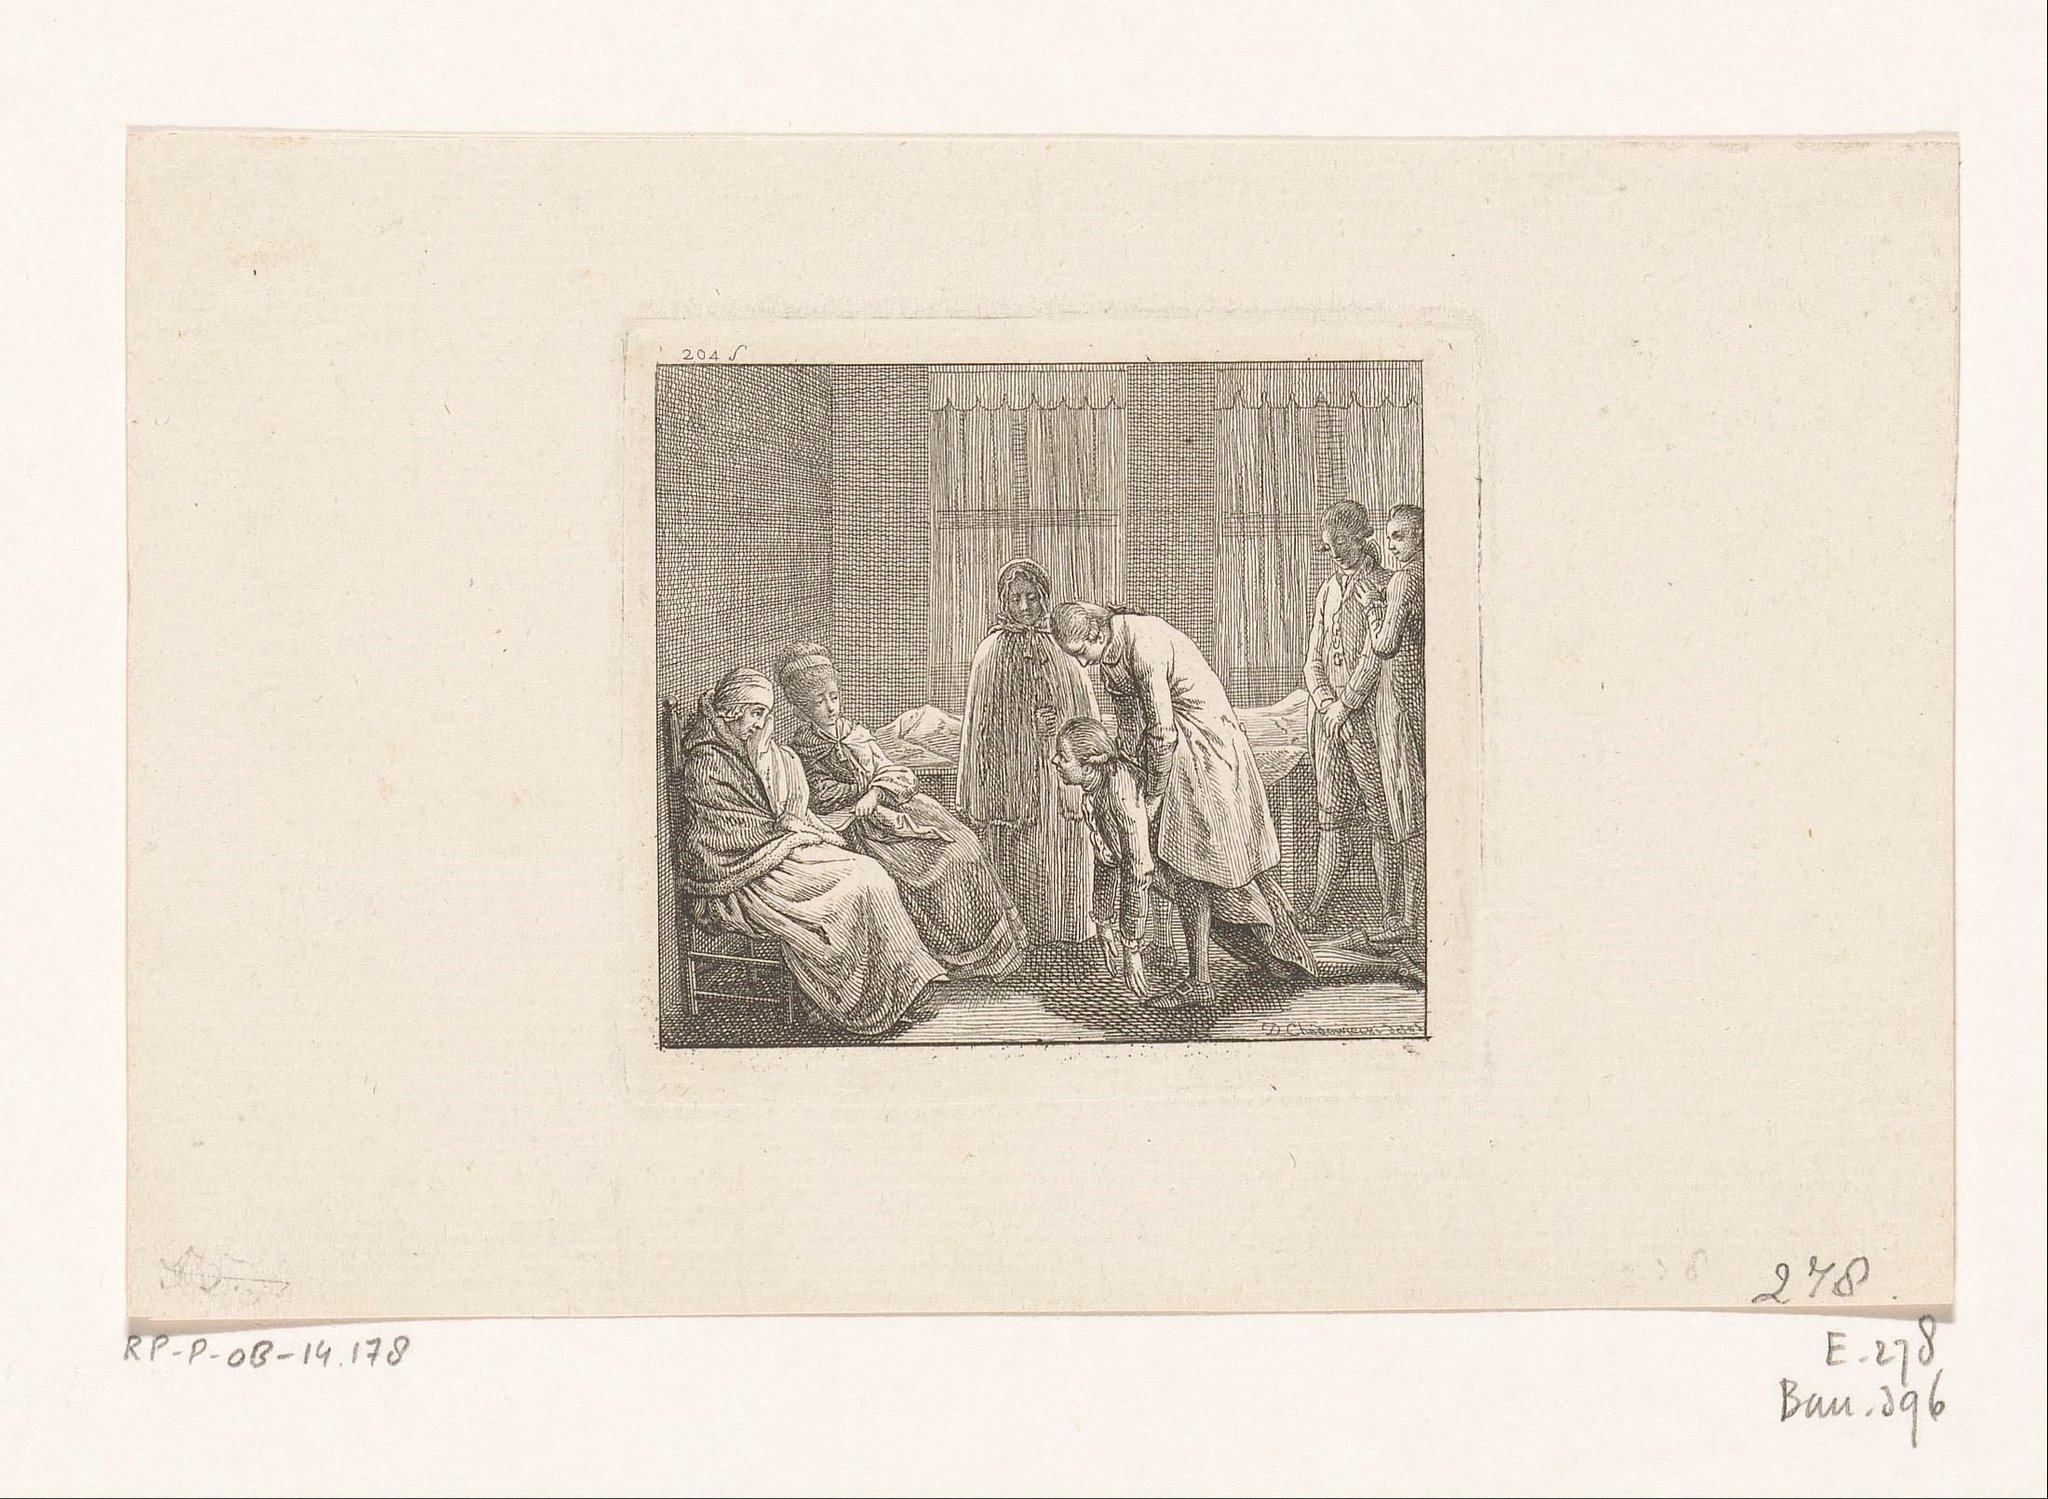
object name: print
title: Benning valt op zijn knieën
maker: daniel nikolaus chodowiecki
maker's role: draughtsman, print maker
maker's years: 1726-1801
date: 1778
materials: paper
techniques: etching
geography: berlin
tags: literature, deathbed, weeping, kneeling on both knees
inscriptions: collector's mark: Lugt 2228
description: In een vertrek zijn Clara, Feldheim en zijn tante, Henriette's moeder en de waardin bij elkaar gekomen vanwege de dood van Henriette, die onder een doek opgebaard ligt. Plotseling komt Benning binnen die op zijn knieën neervalt, uitroepend dat hij schuldig is aan Henriette's dood. Linksboven genummerd: 204 S.